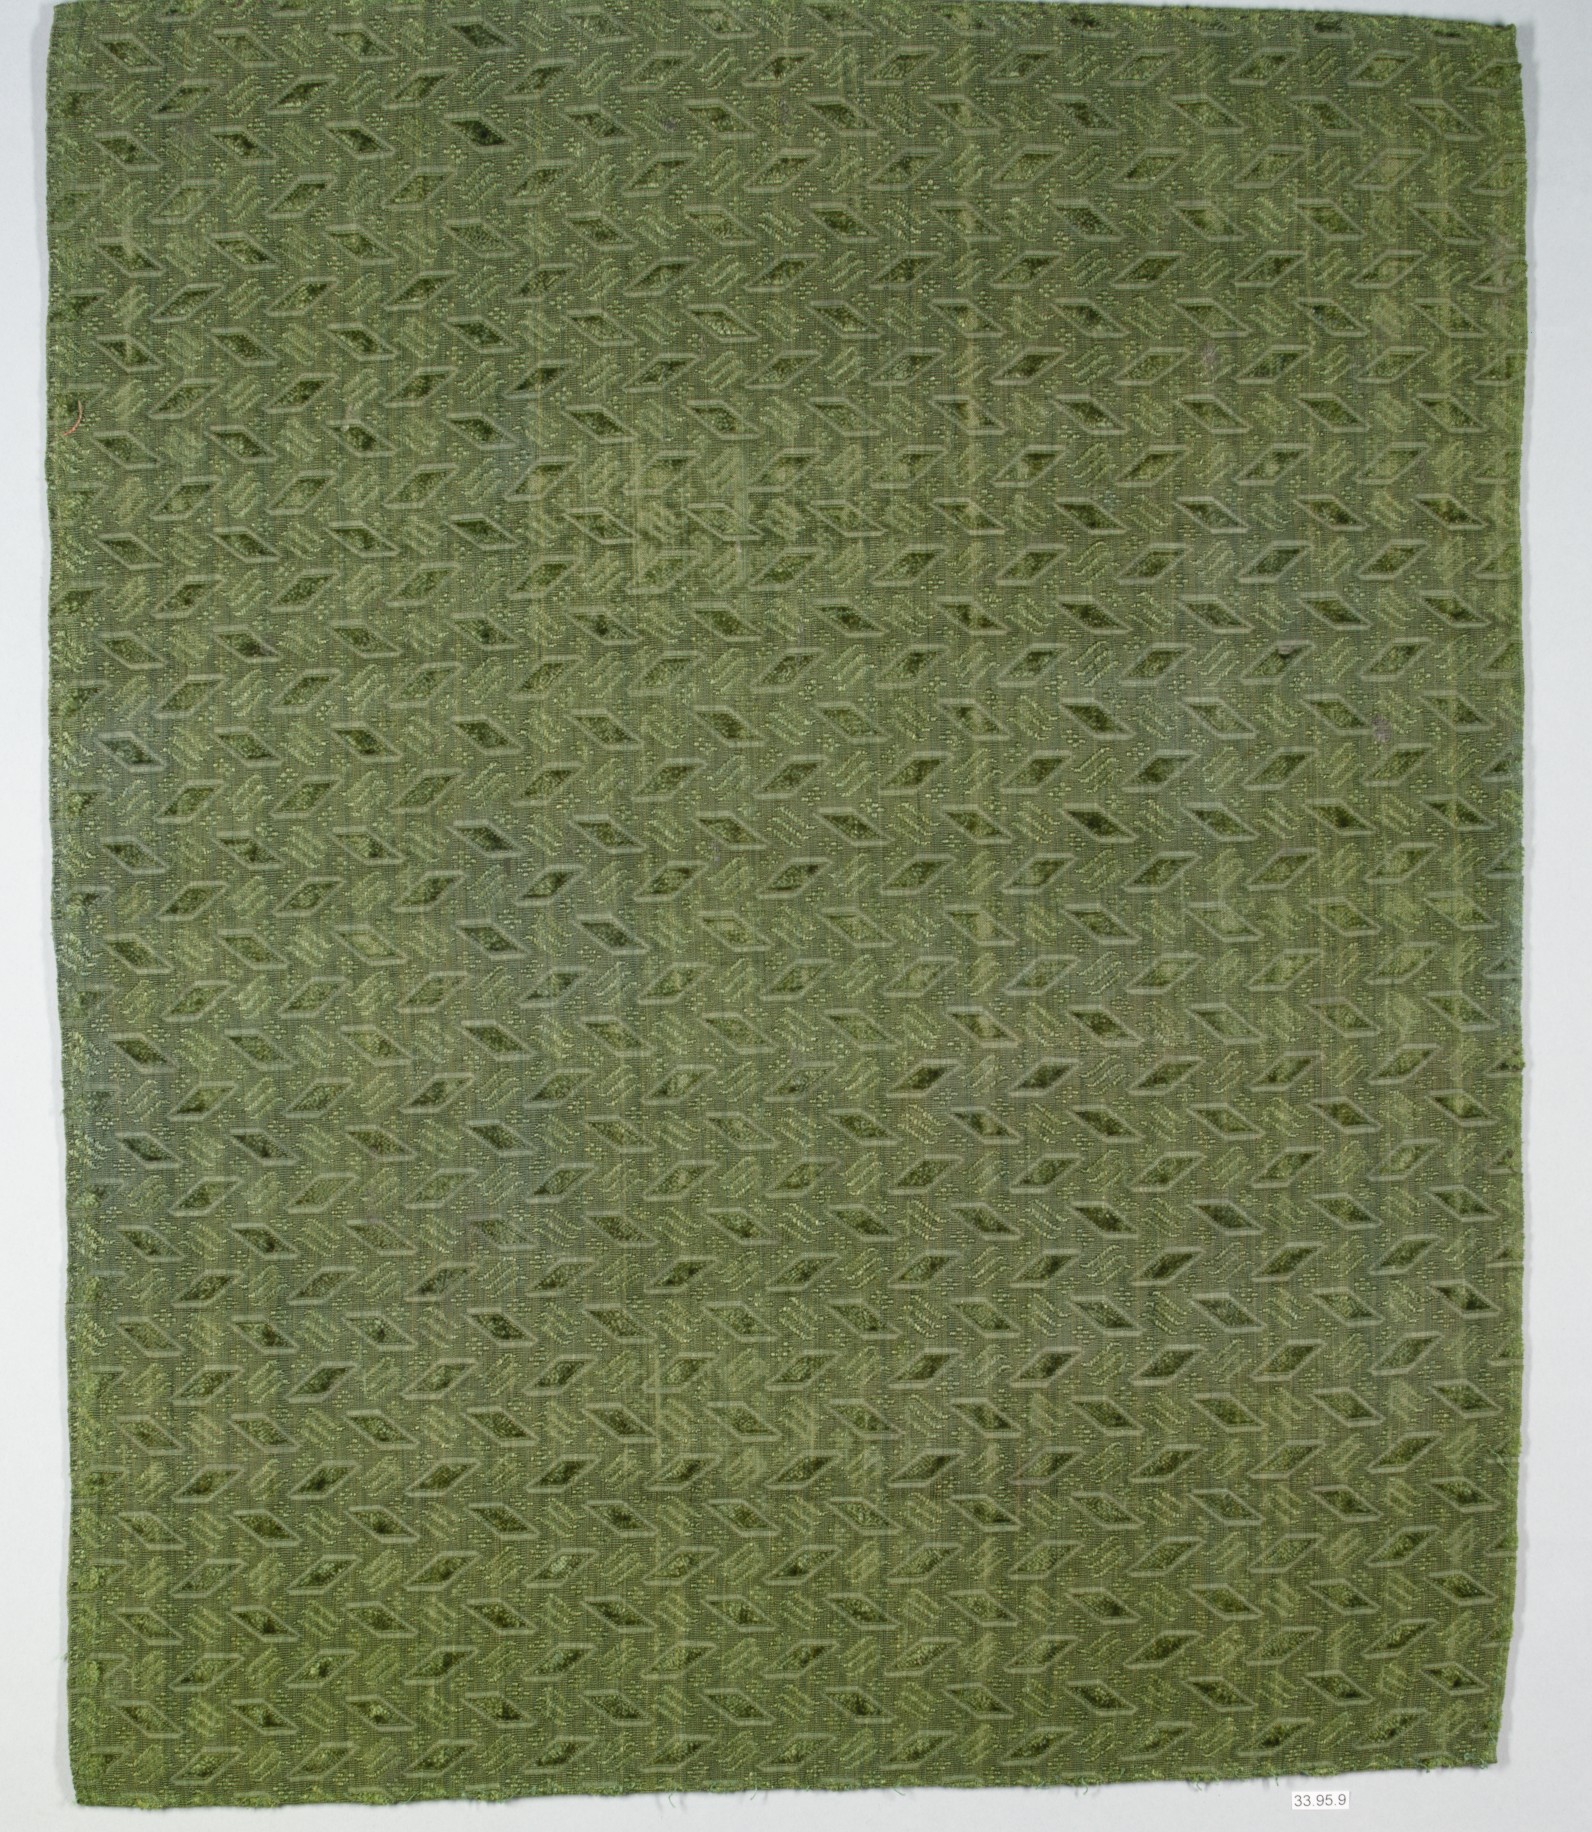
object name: piece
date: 1501-1700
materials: silk